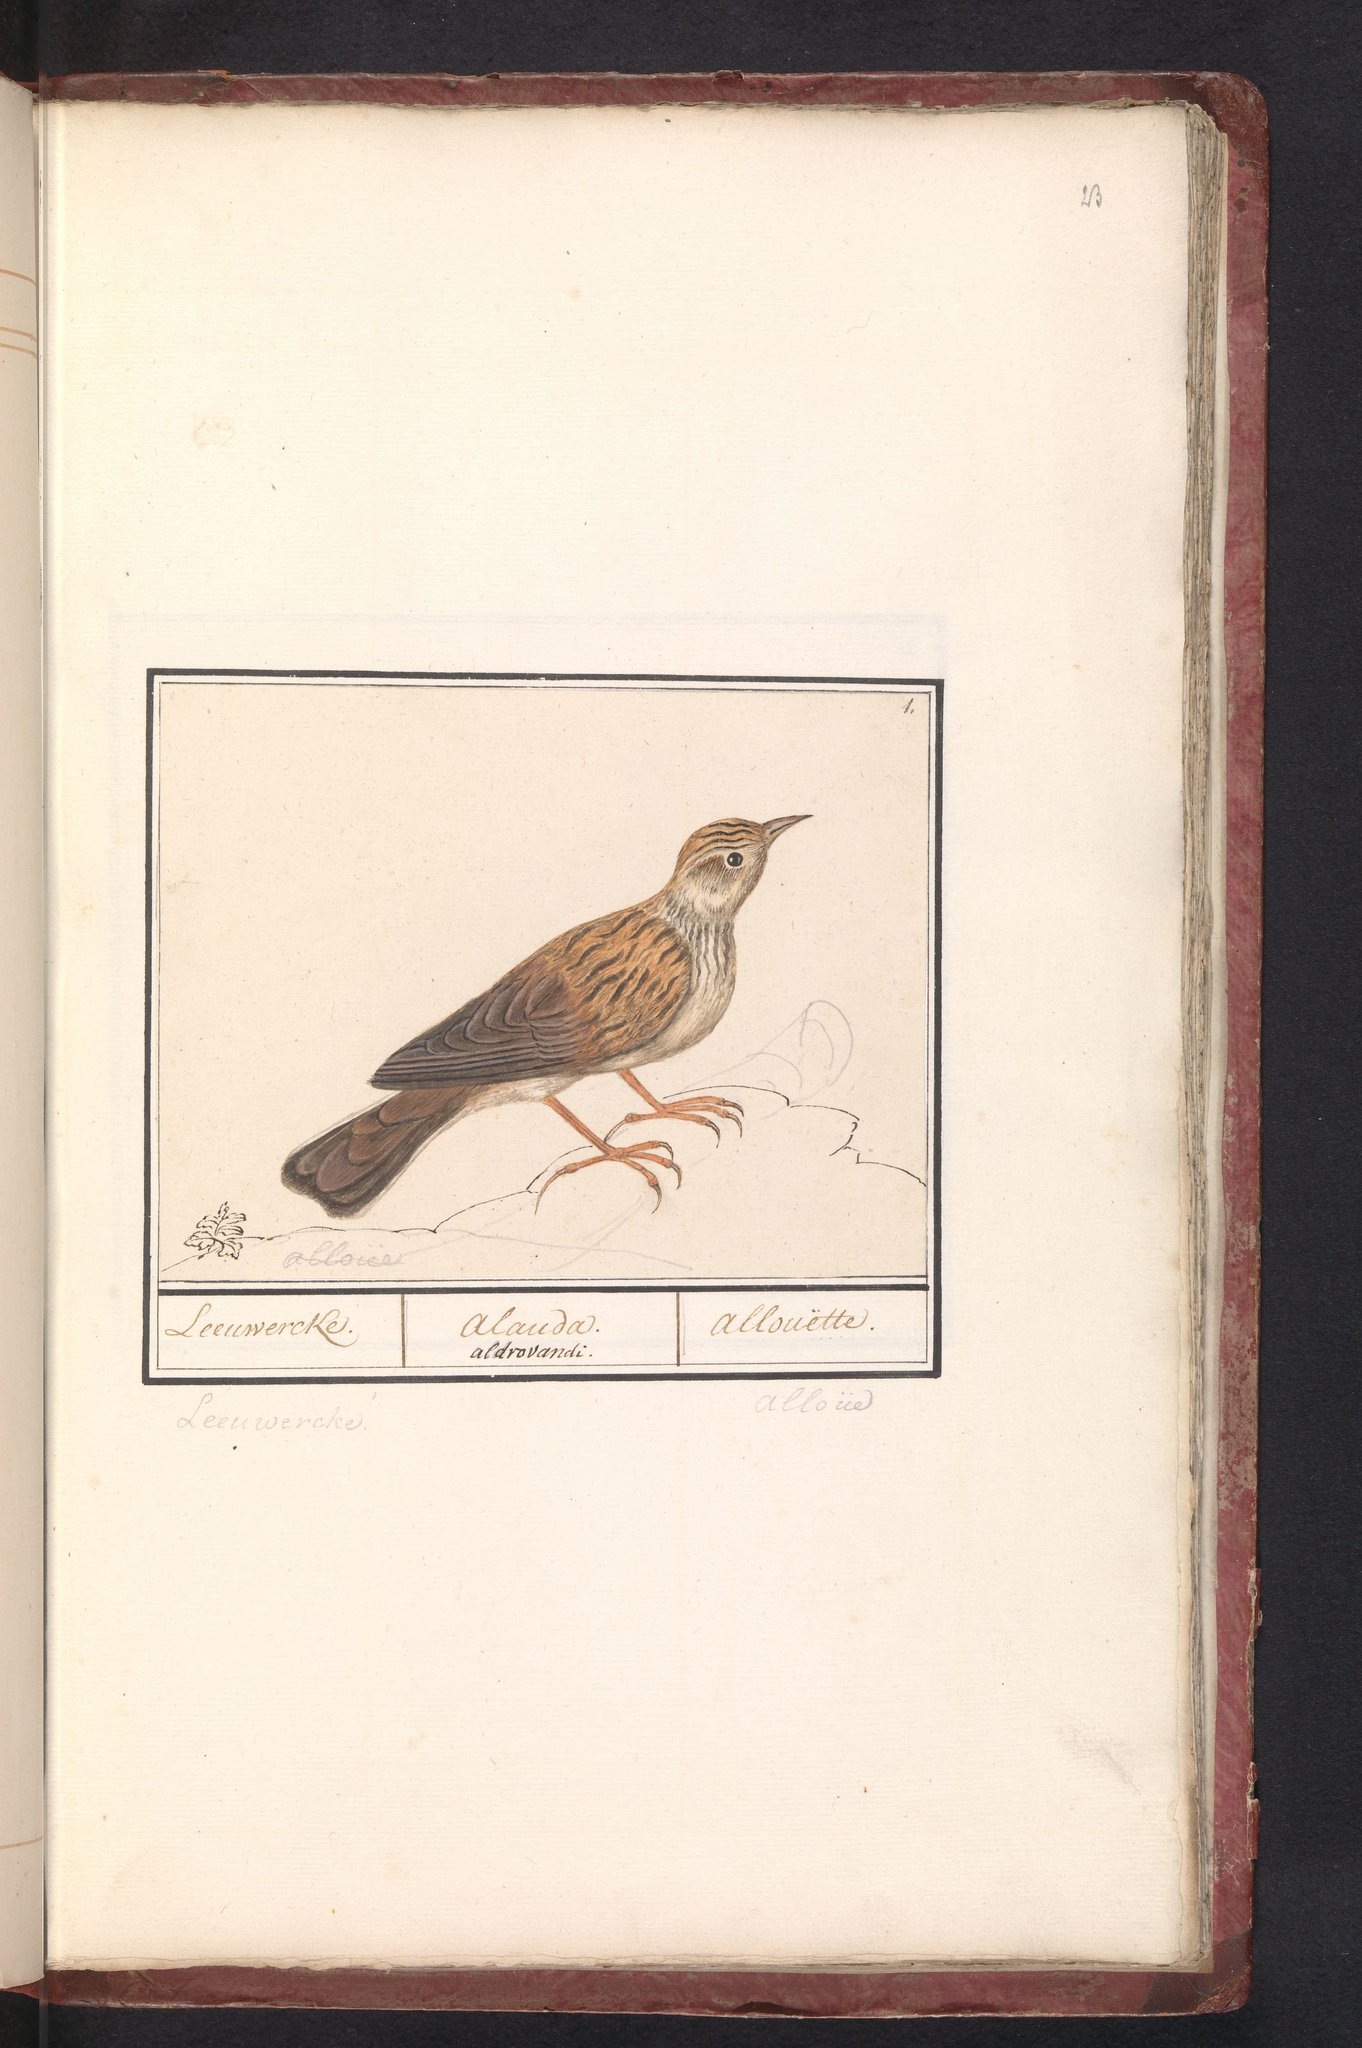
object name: drawing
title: Leeuwerik (Alaudidae)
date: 1596-1610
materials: paint, ink, paper, pencil, watercolor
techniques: brush, pen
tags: song-birds: lark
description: Leeuwerik. Genummerd rechtsboven: 1. Onderdeel van het tweede album met tekeningen van vogels. Vierde van twaalf albums met tekeningen van dieren, vogels en planten bekend rond 1600, gemaakt in opdracht van keizer Rudolf II. Met toelichting in Nederlands, Latijn en Frans.